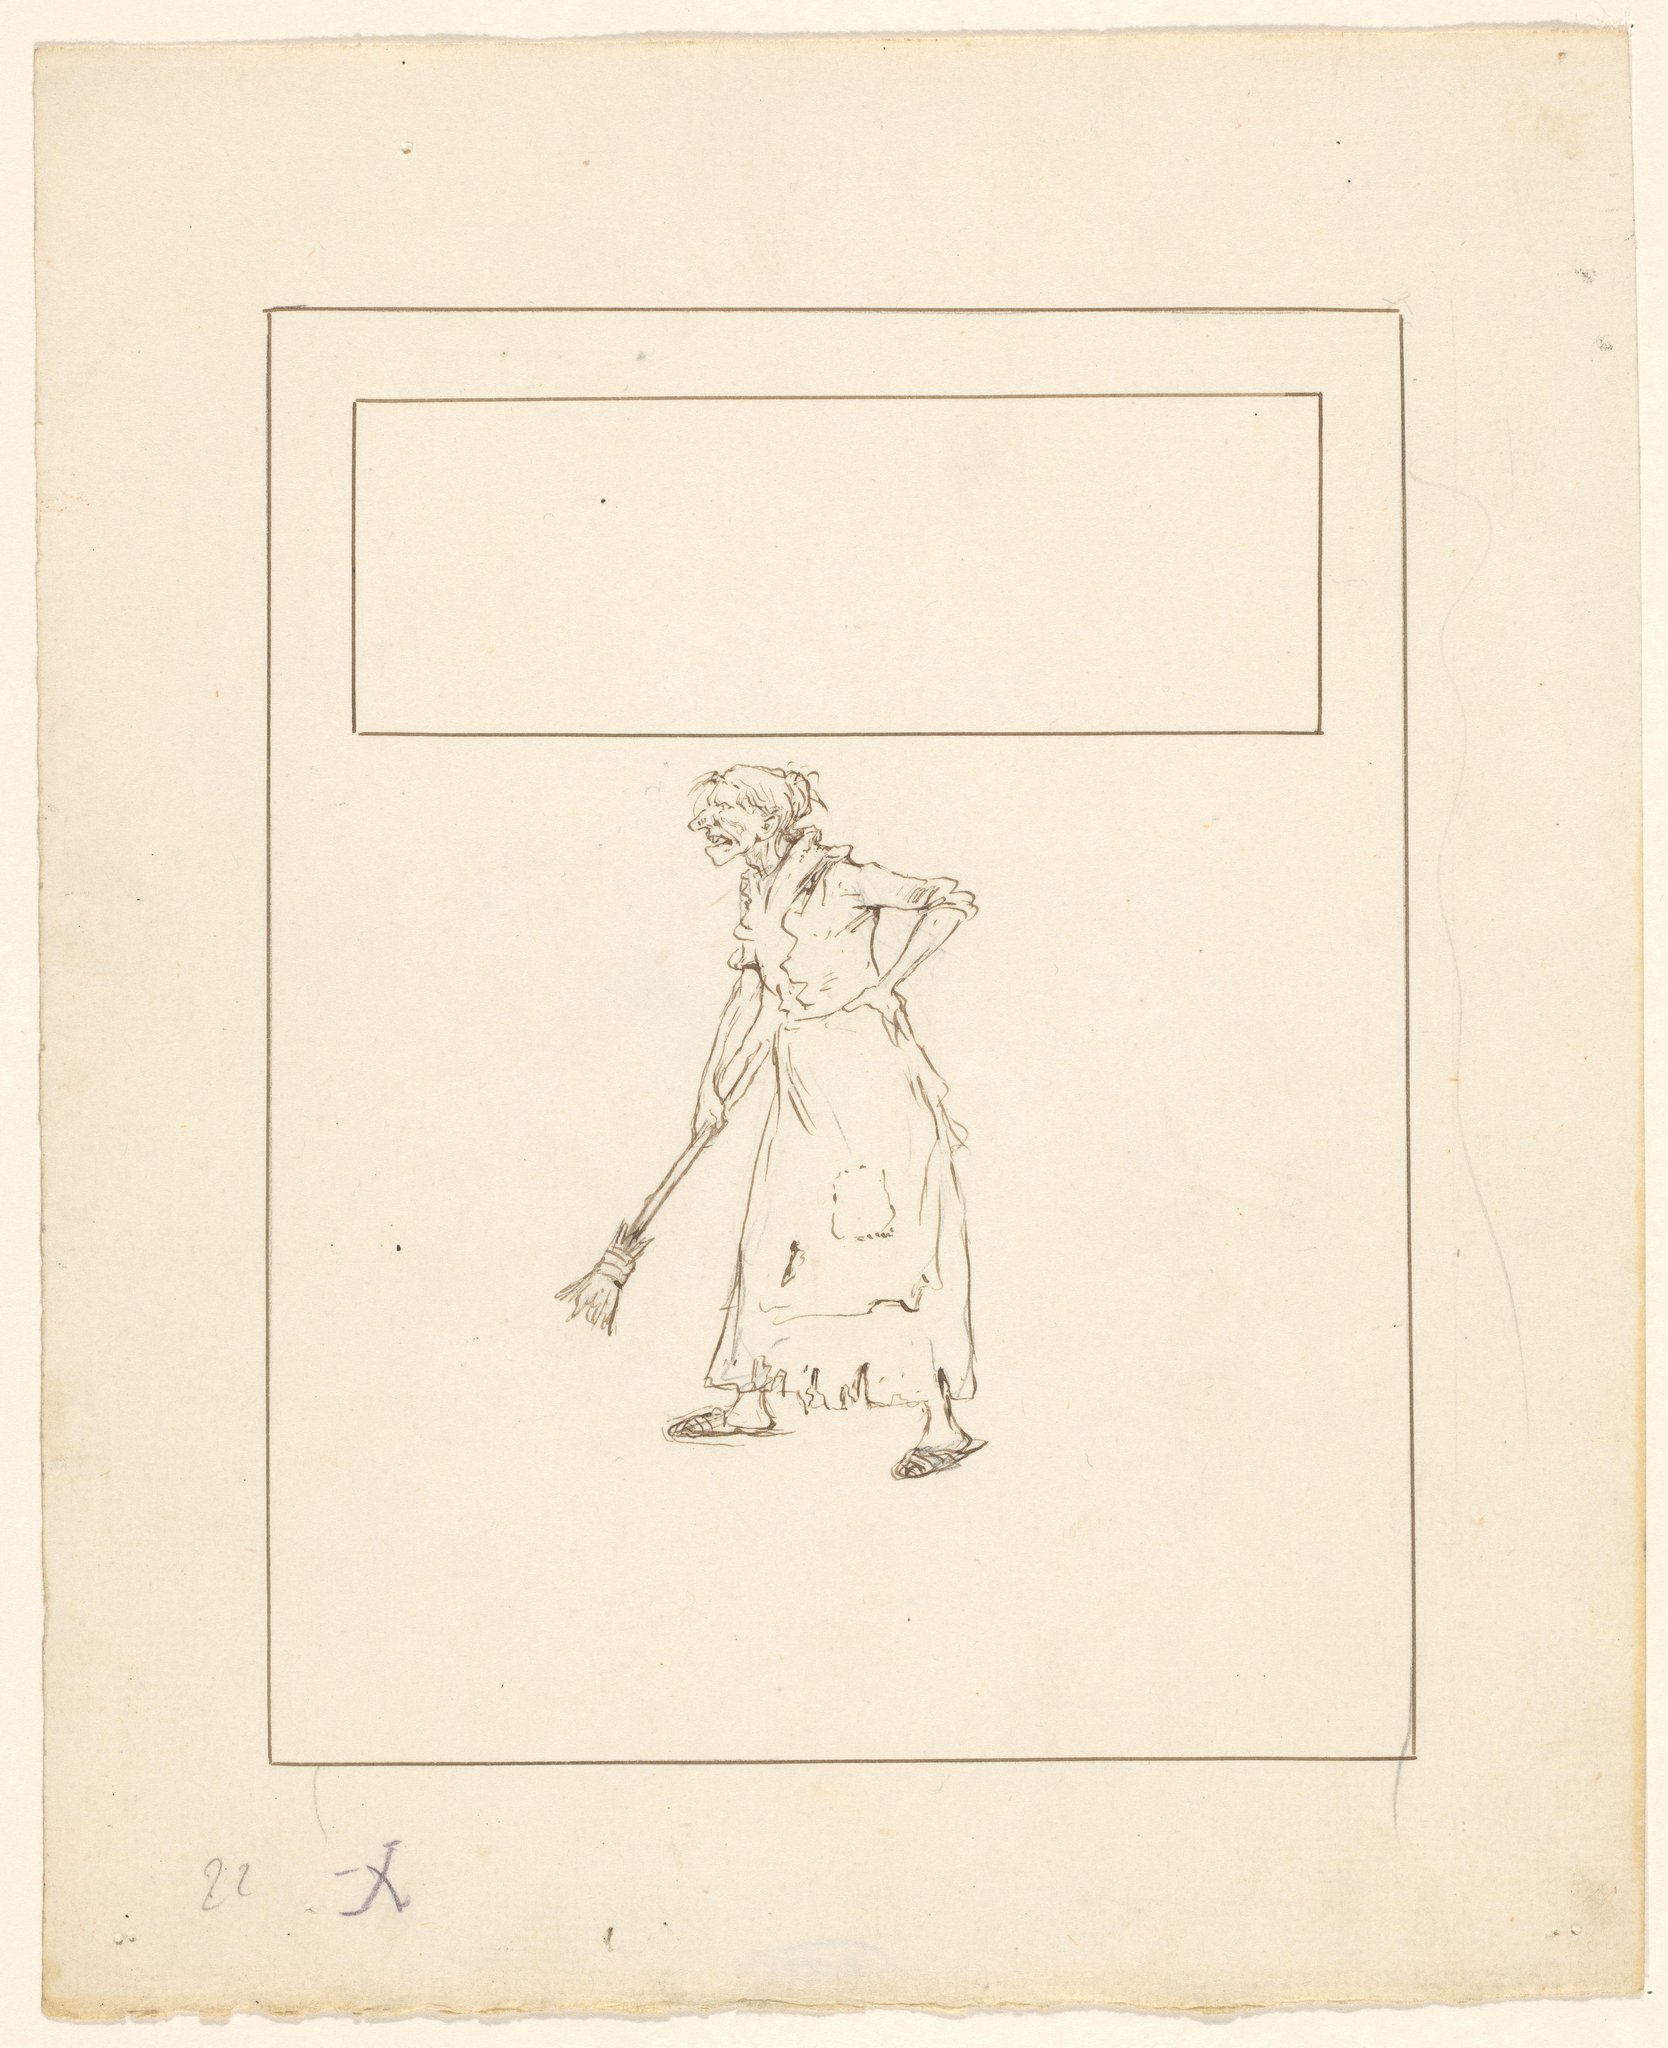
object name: drawing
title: Oude vrouw met bezem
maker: Anonymous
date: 1880-1910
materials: ink, paper, pencil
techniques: pen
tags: clothed in rags, ugly old woman, hag, (household) utensils and implements (with name)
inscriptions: number: ‘22 X’, collector's mark: Lugt 2228a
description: Een oude vrouw in gerafelde en verstelde kleding staat met een bezem in de hand.